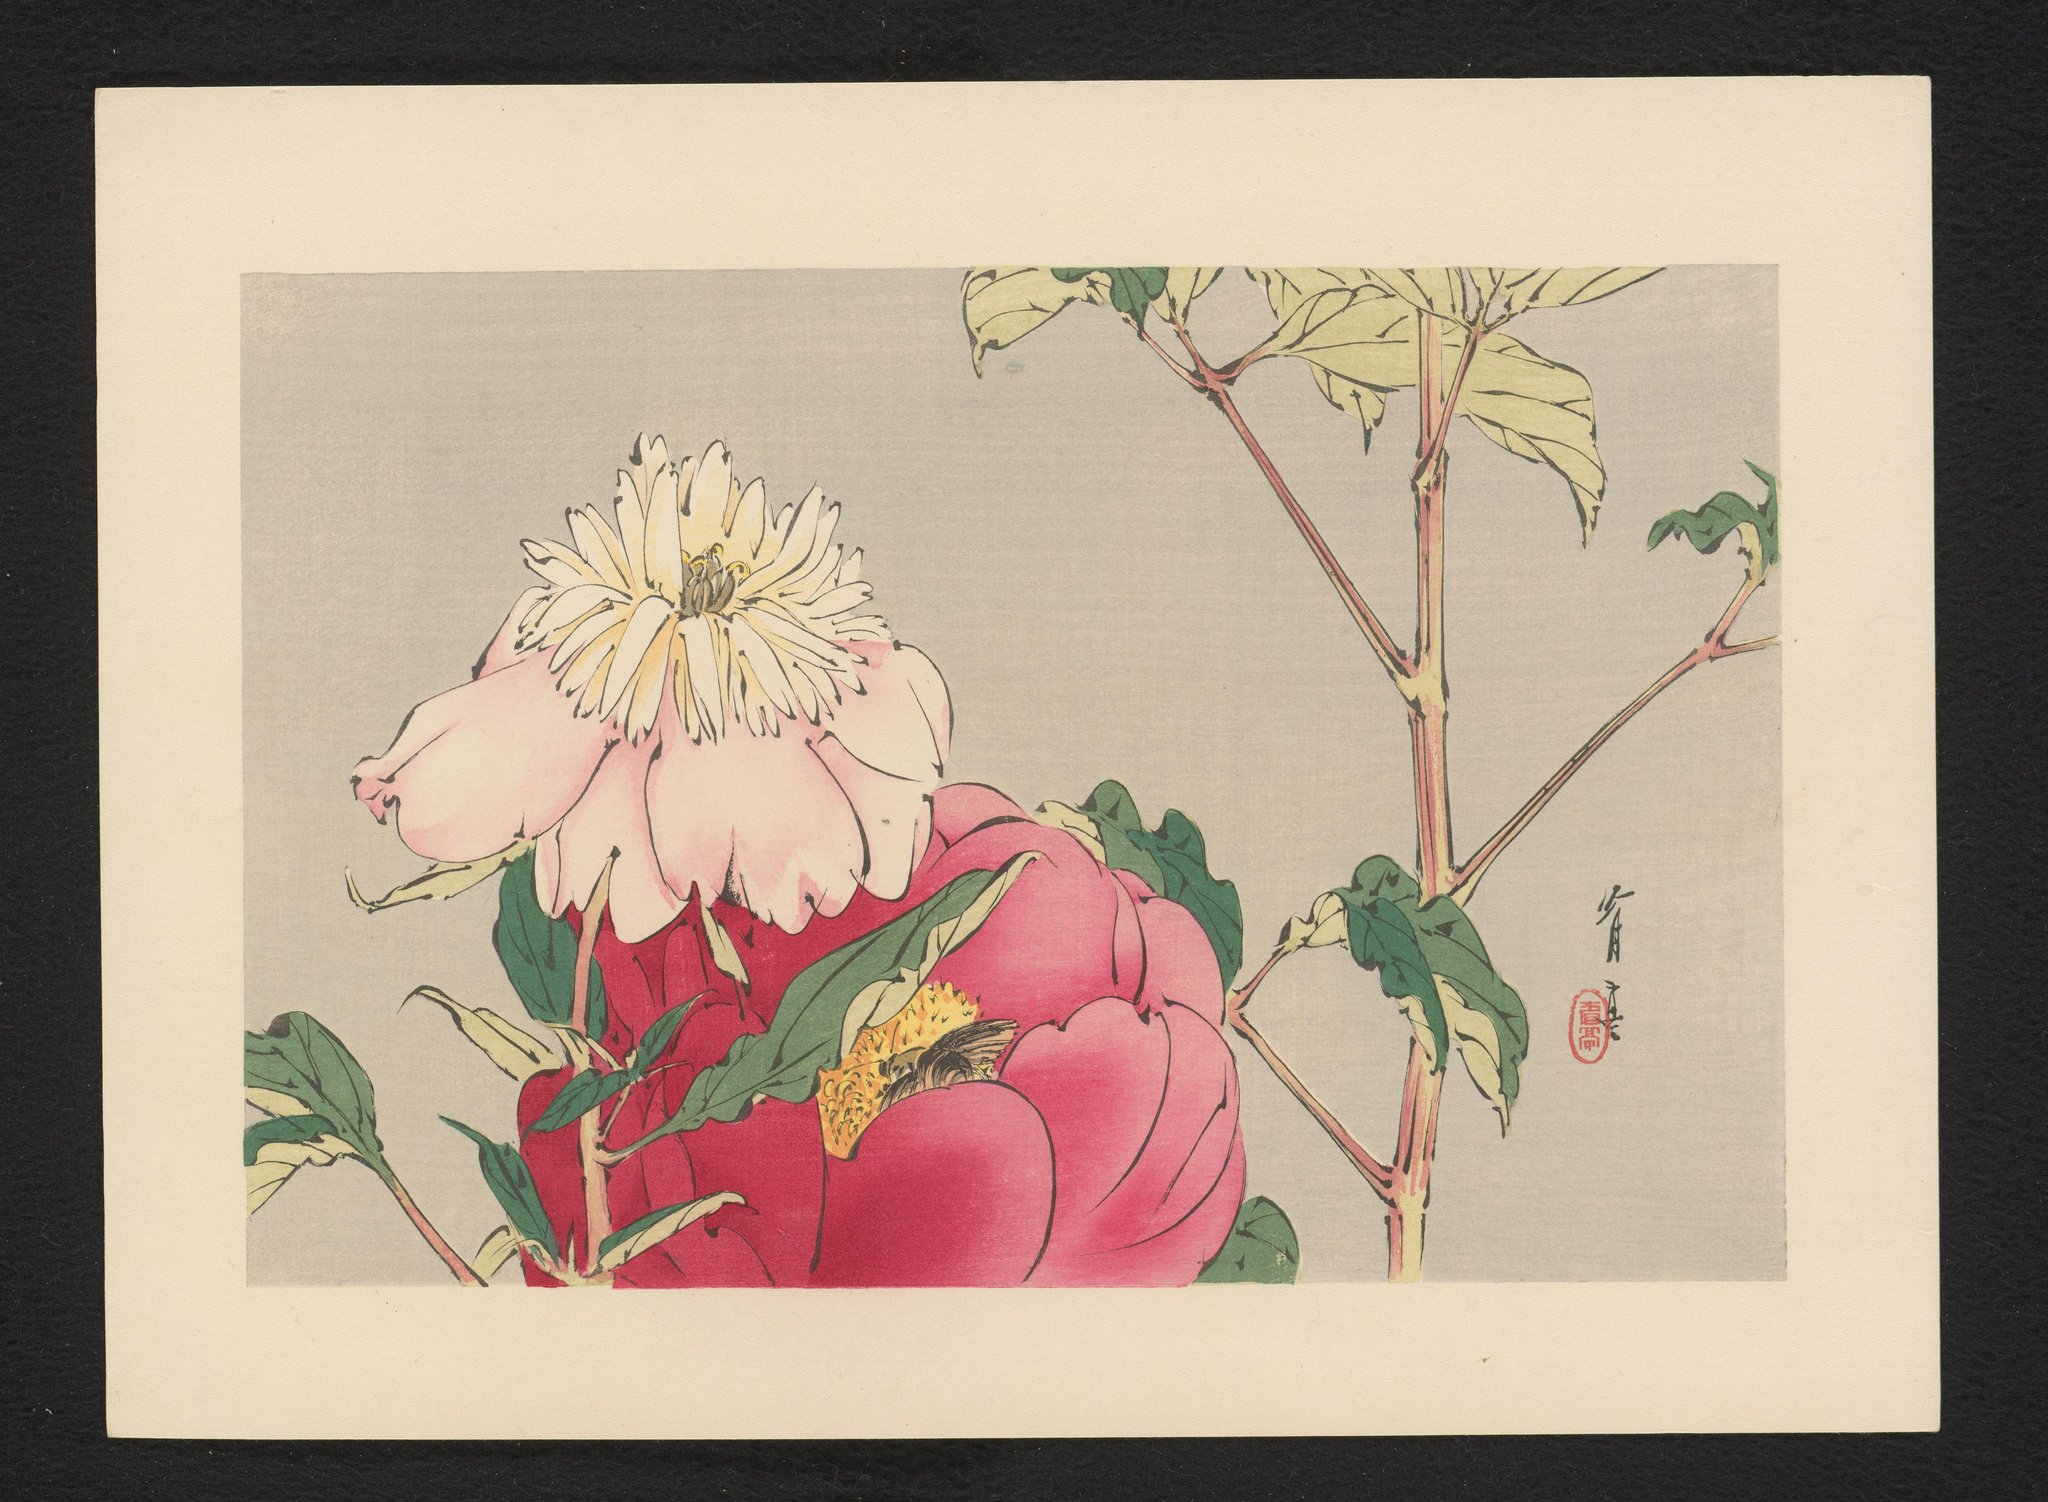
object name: print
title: Pioenrozen met bij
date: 1916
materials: paper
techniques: woodcut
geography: tokyo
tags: flowers